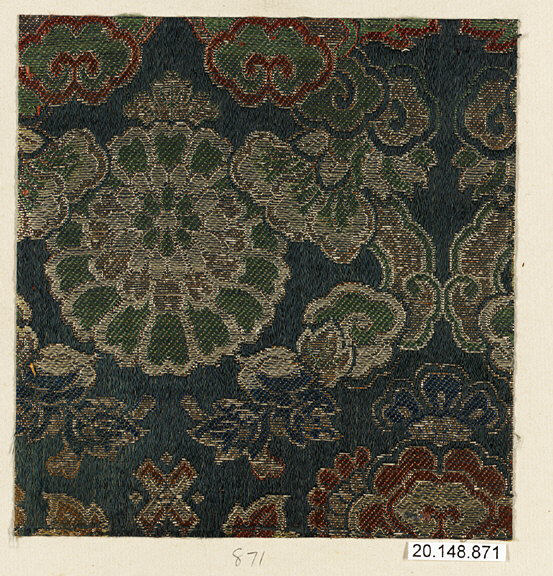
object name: piece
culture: japanese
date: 1601-1700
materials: silk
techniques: compound weave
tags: flowers